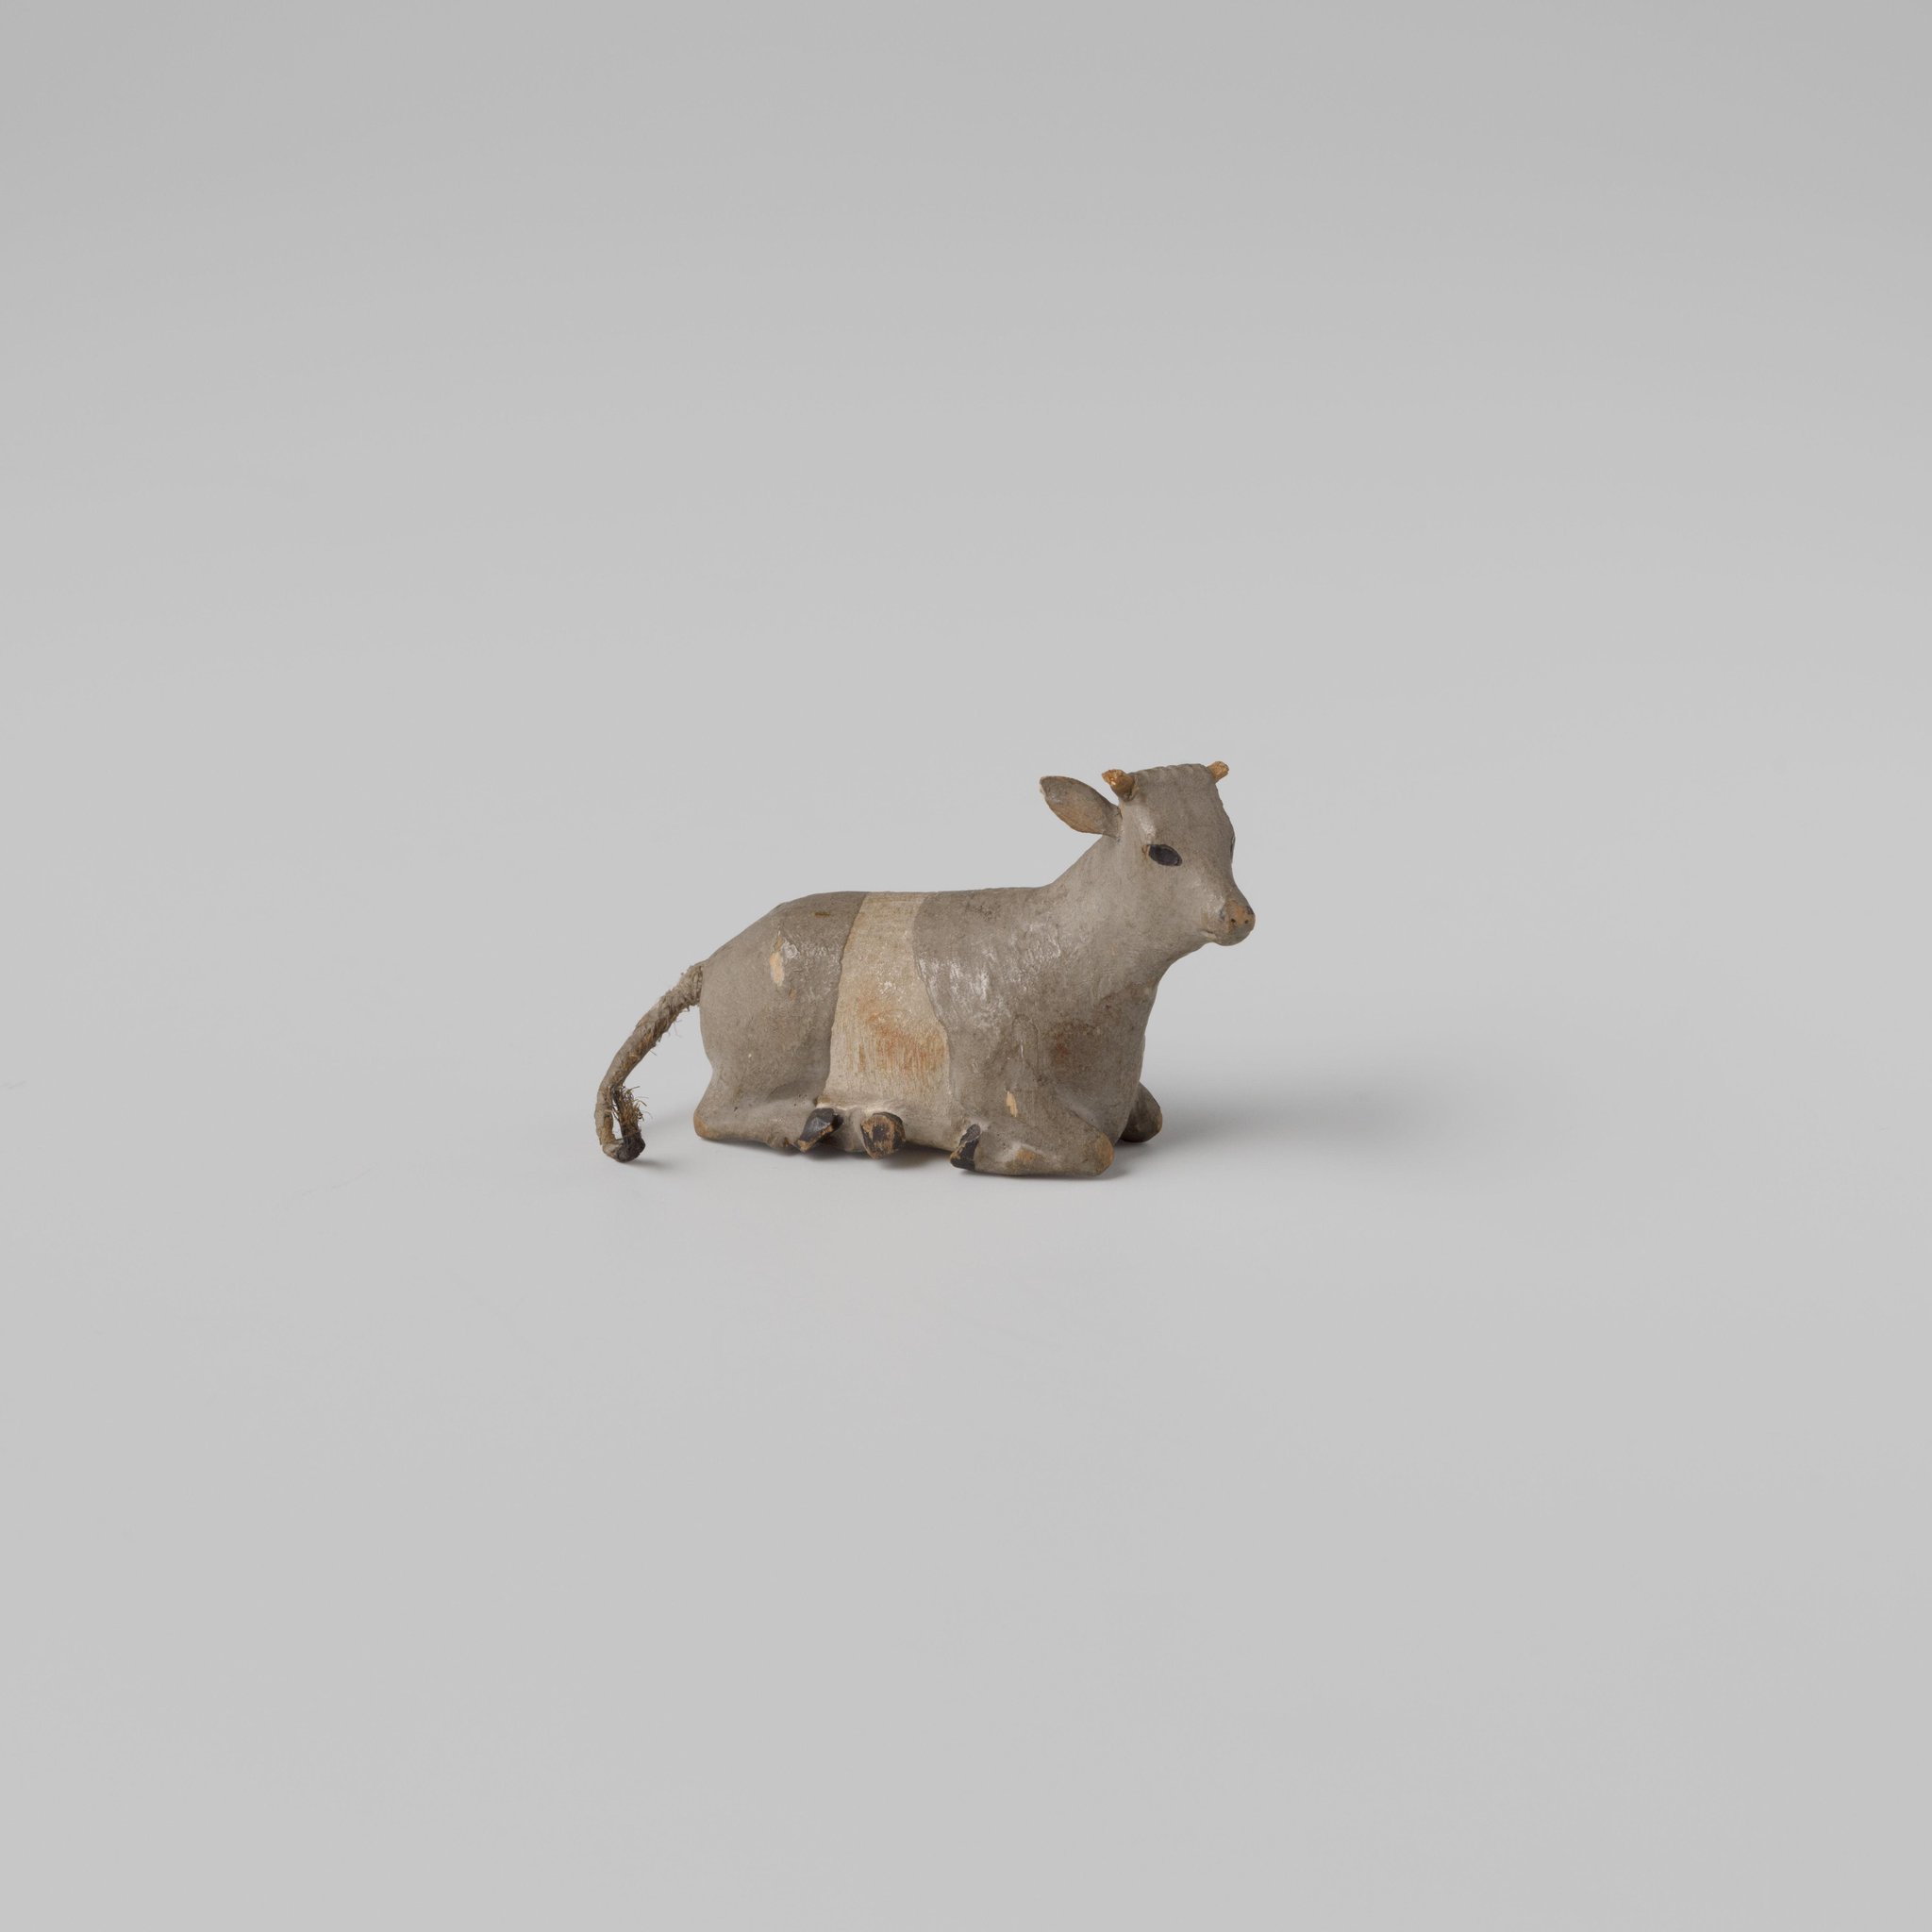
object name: miniature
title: Liggende koe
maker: Anonymous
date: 1700-1799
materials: wood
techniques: cutting, painted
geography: germany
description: Liggende koe, gesneden uit hout, beschilderd in grijstinten.